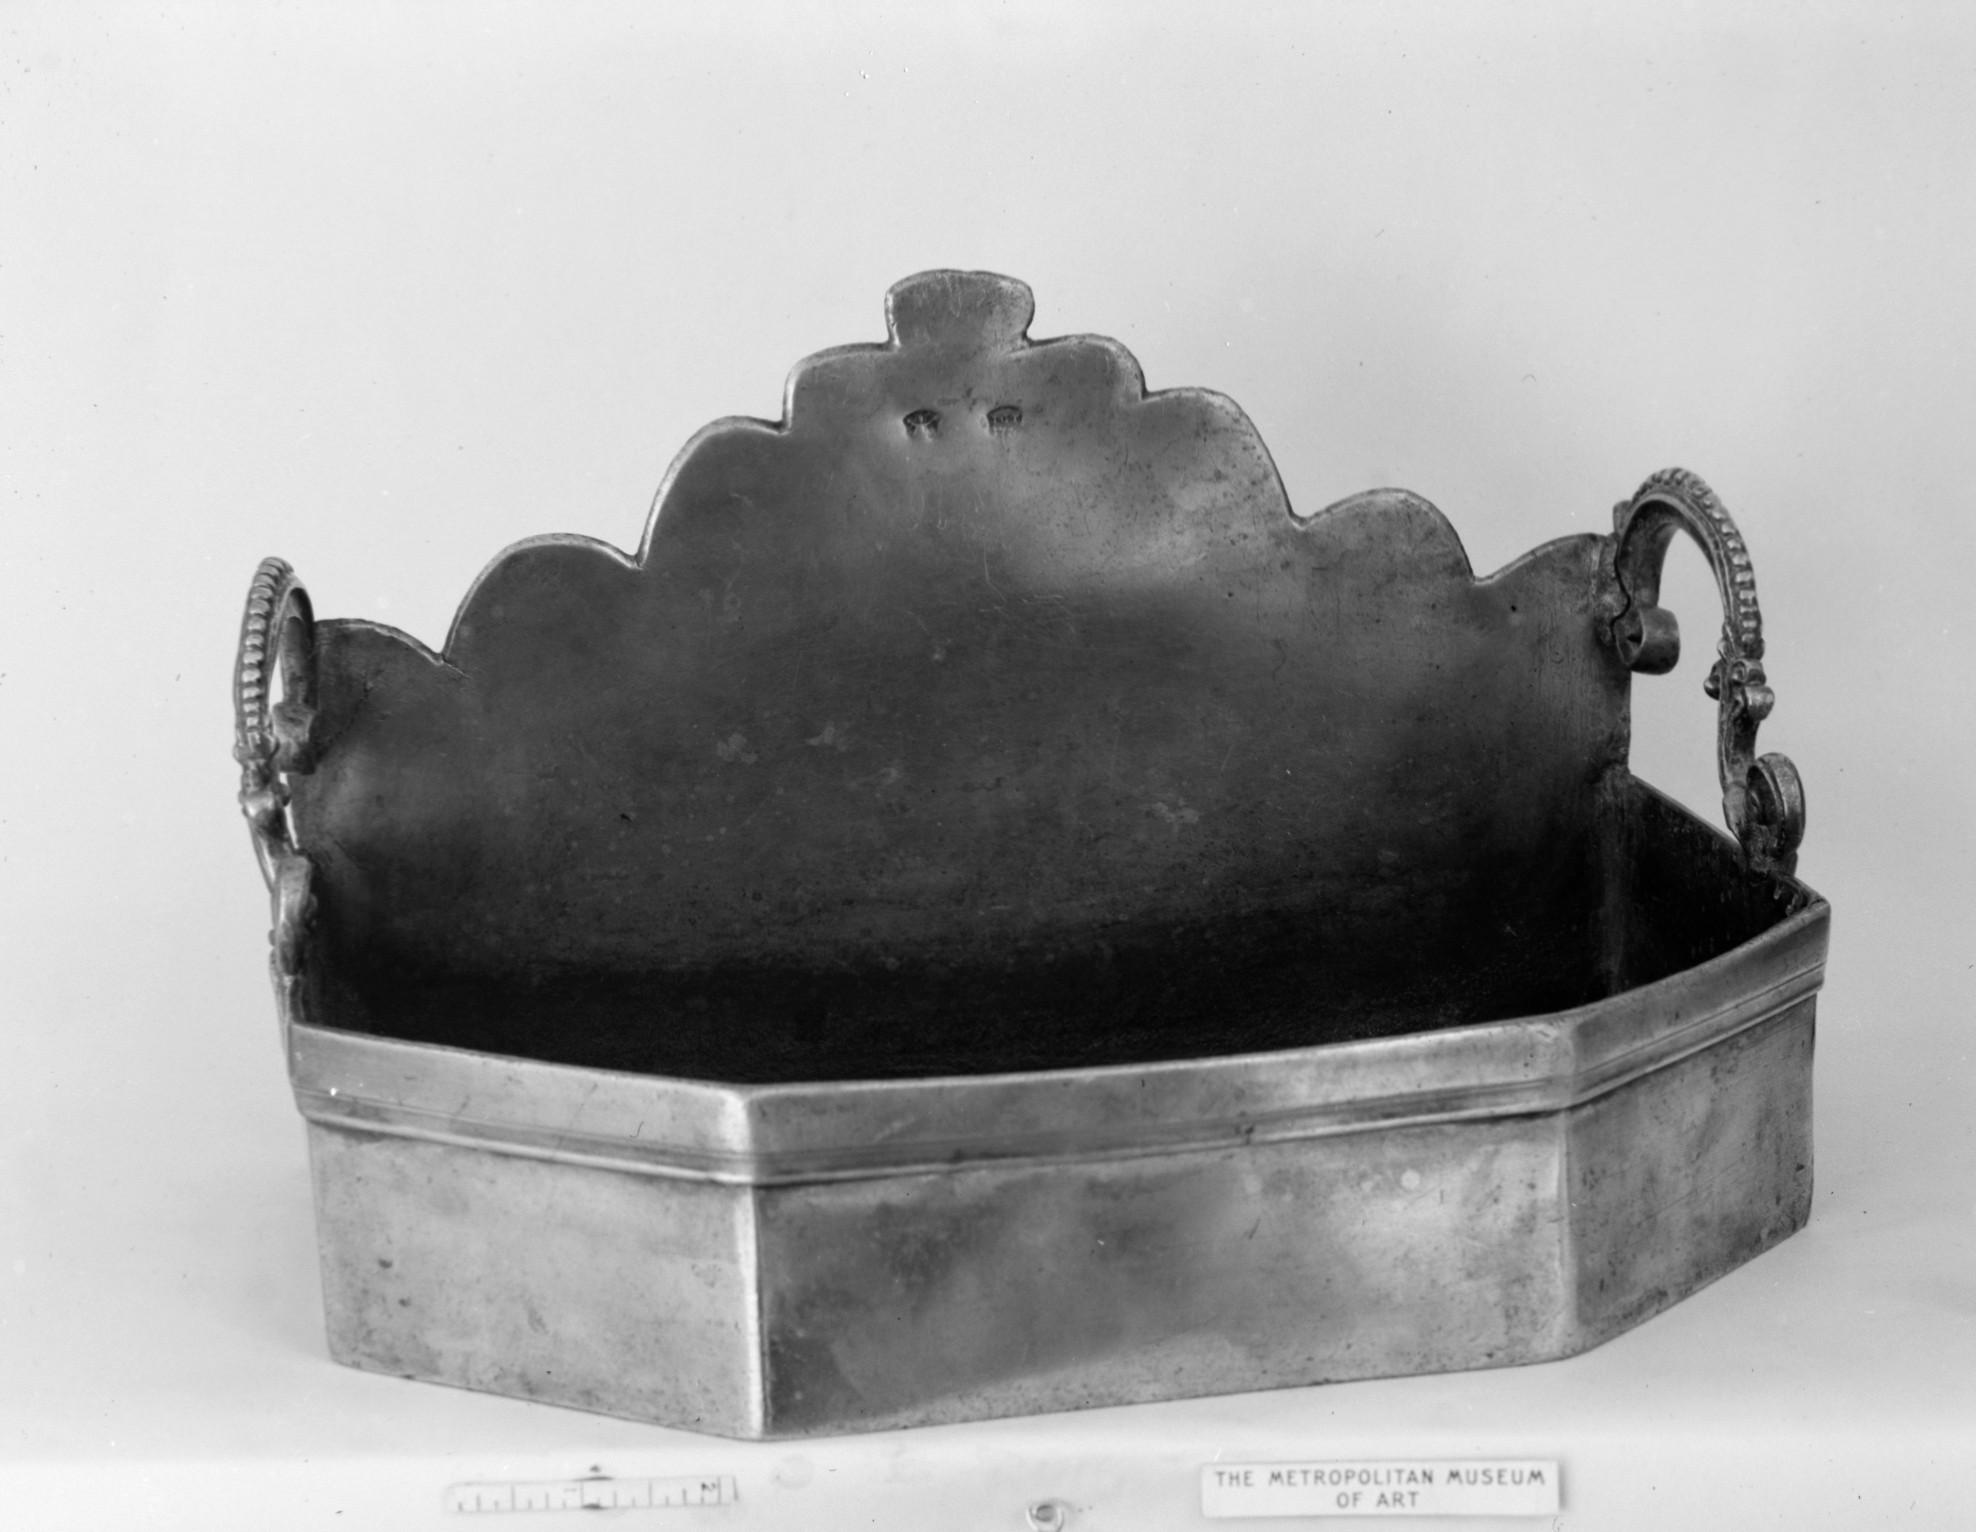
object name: lavatory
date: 1701-1800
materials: pewter